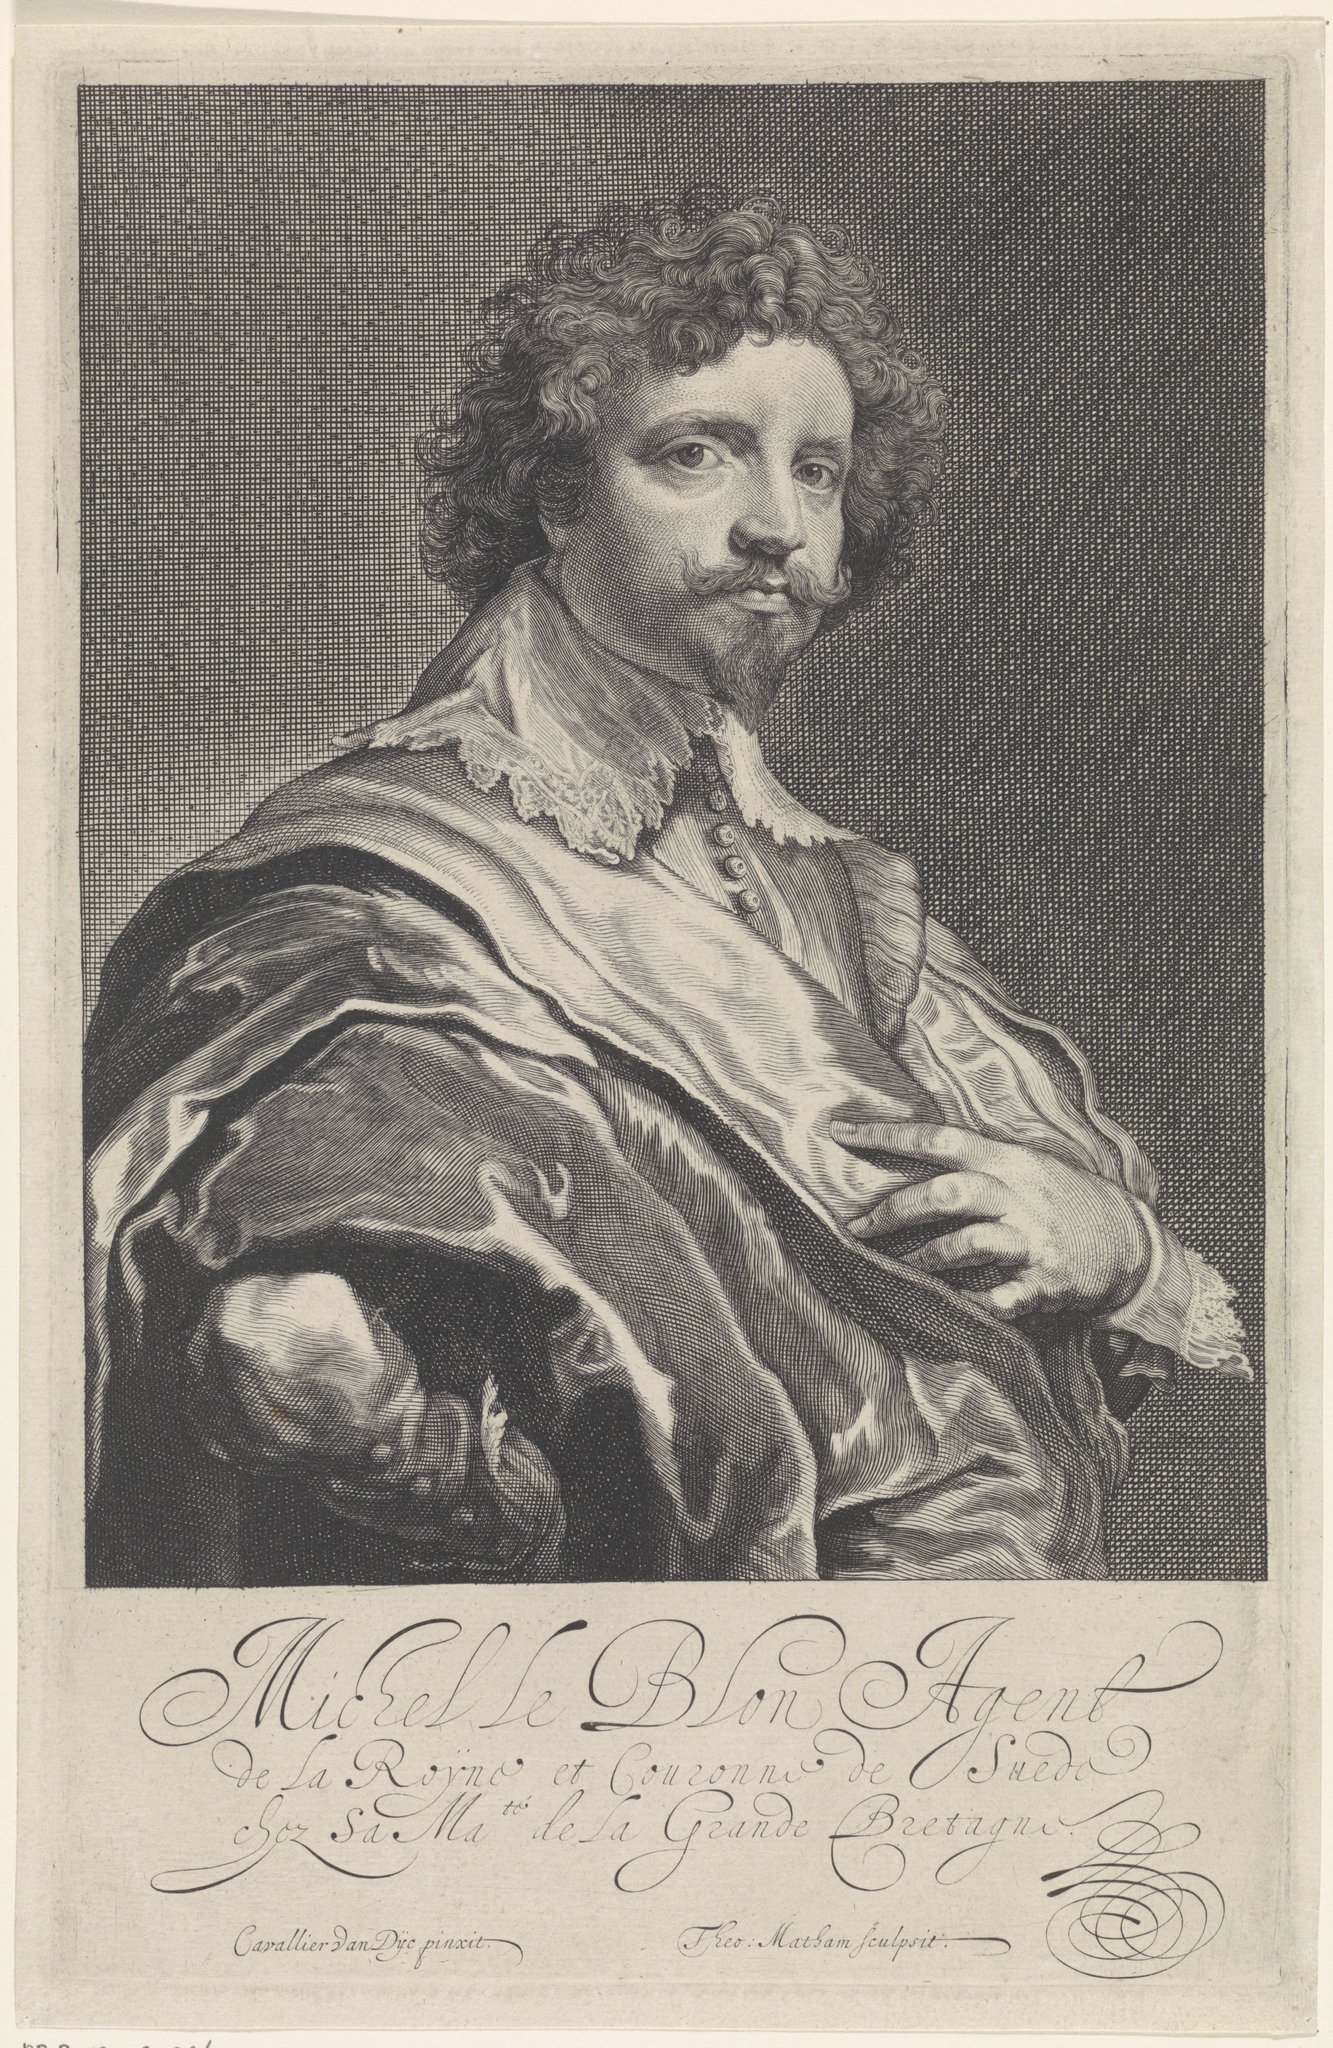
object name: print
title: Portret van Michiel le Blon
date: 1625-1676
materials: paper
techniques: engraving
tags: amsterdam, print maker, michiel le blon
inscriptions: collector's mark: Lugt 240